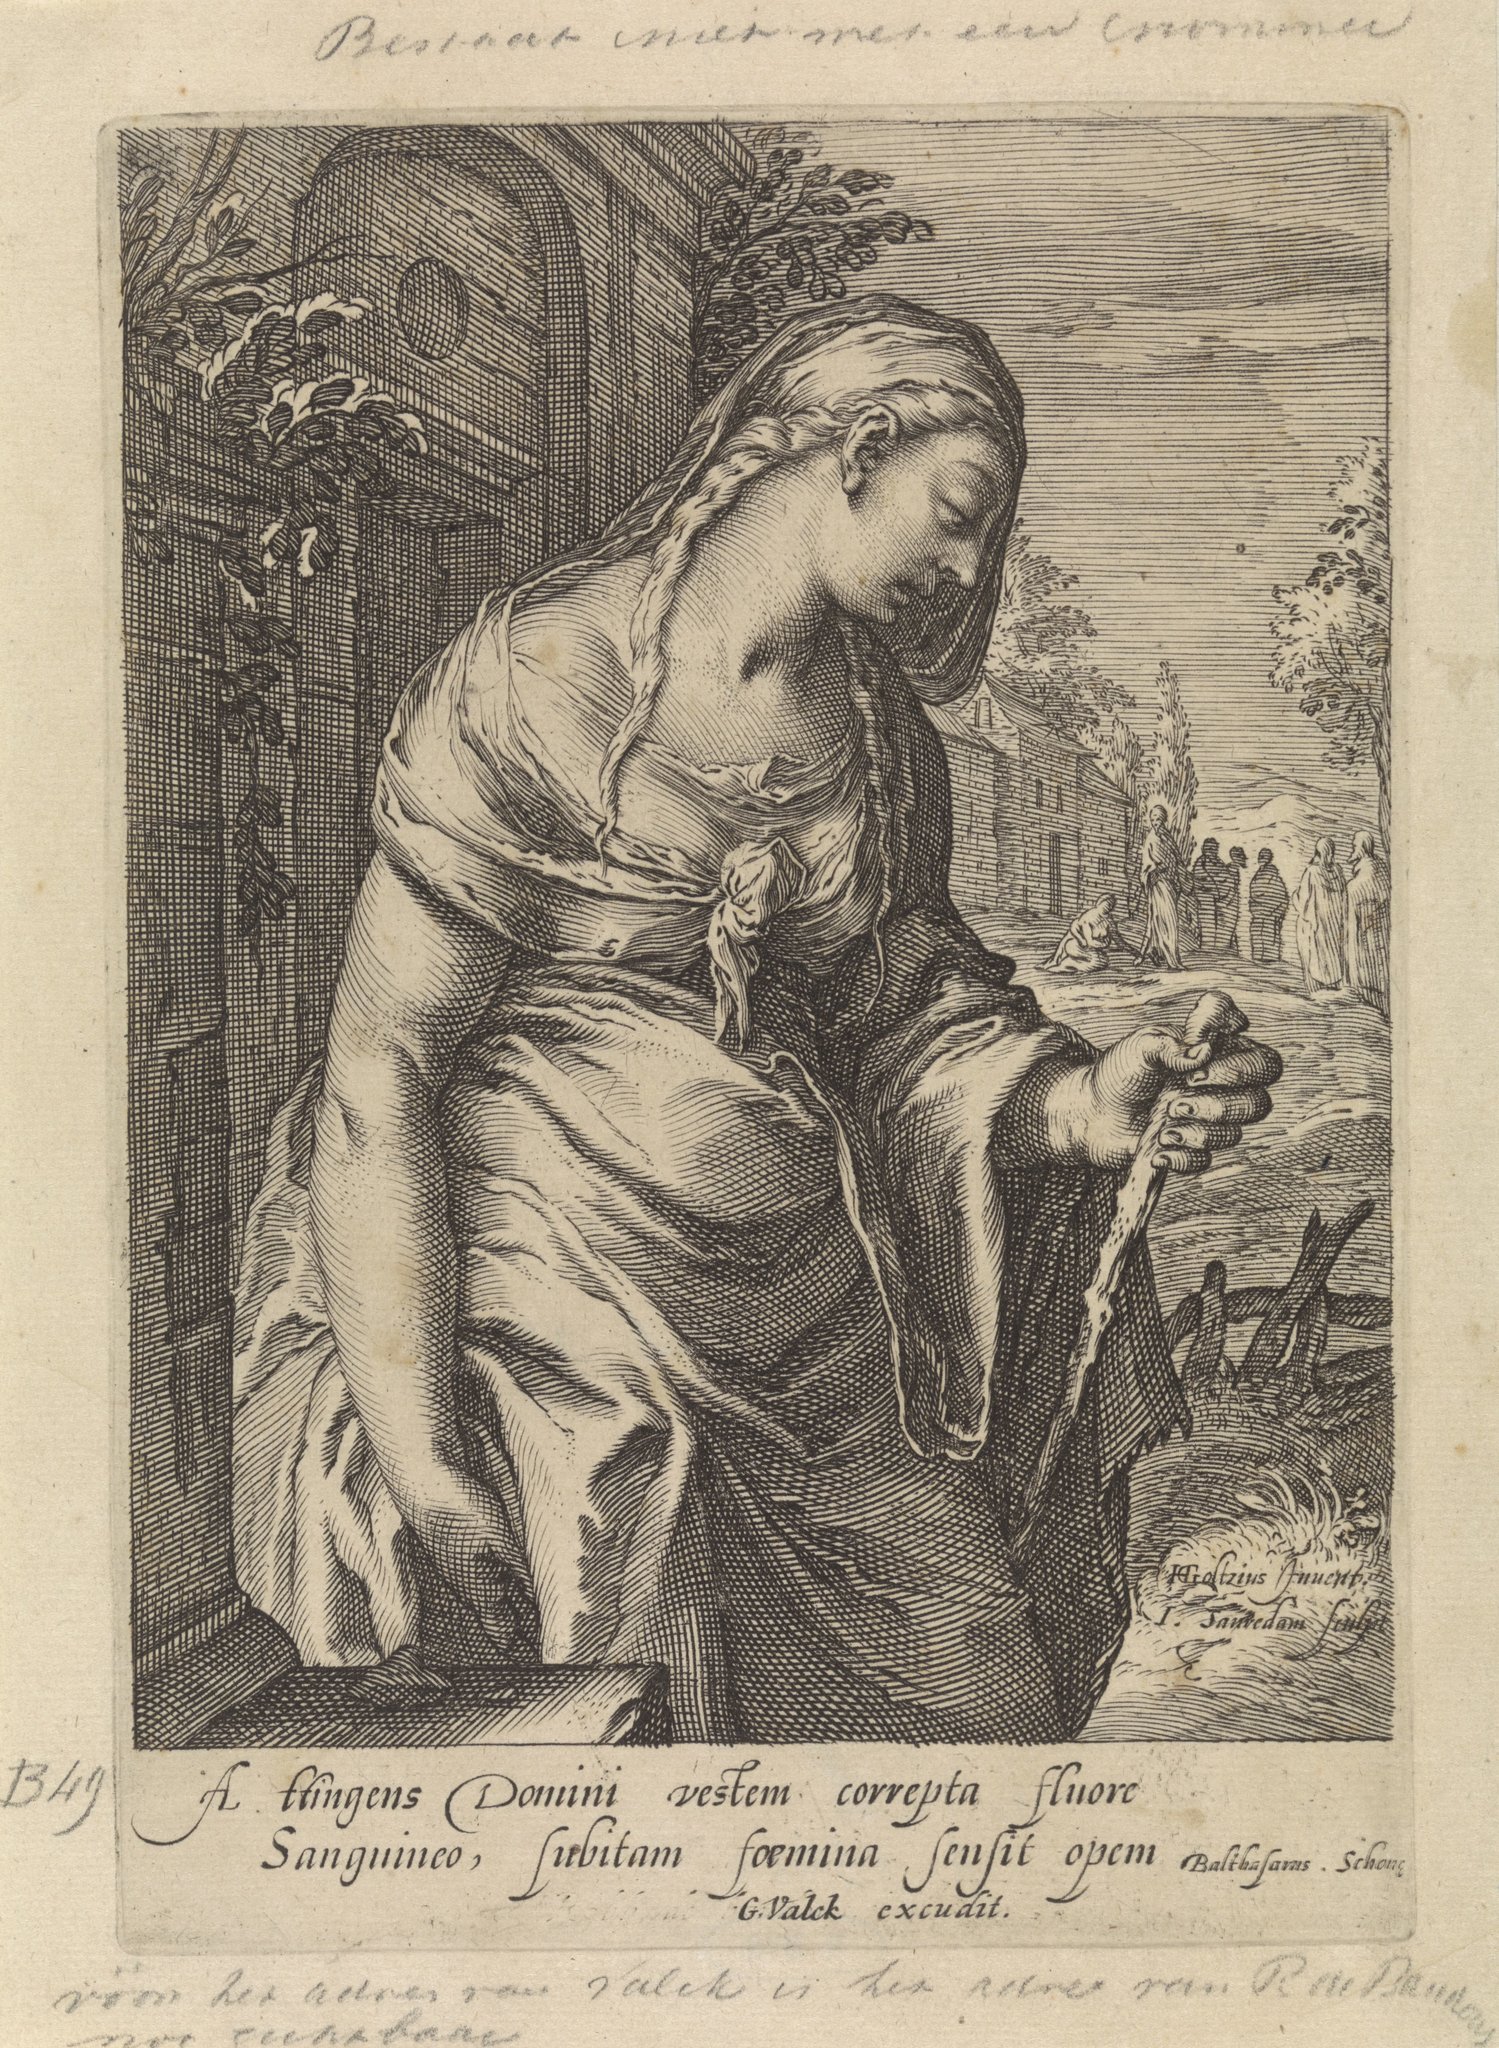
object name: print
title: De bloedvloeiende vrouw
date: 1661-1726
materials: paper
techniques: engraving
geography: northern netherlands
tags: healing of a woman with an issue of blood: she kneels before christ after having touched his robe (matthew 9:20-22; mark 5:25-34; luke 8:43-48)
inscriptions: collector's mark: Lugt 2228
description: Op de voorgrond de vrouw die aan bloedvloeiingen leed. Ze loopt gebukt met een wandelstok. Op de achtergrond geneest Christus de vrouw. De prent heeft een Latijns onderschrift en maakt deel uit van een prentserie met beroemde vrouwen uit het Nieuwe Testament.